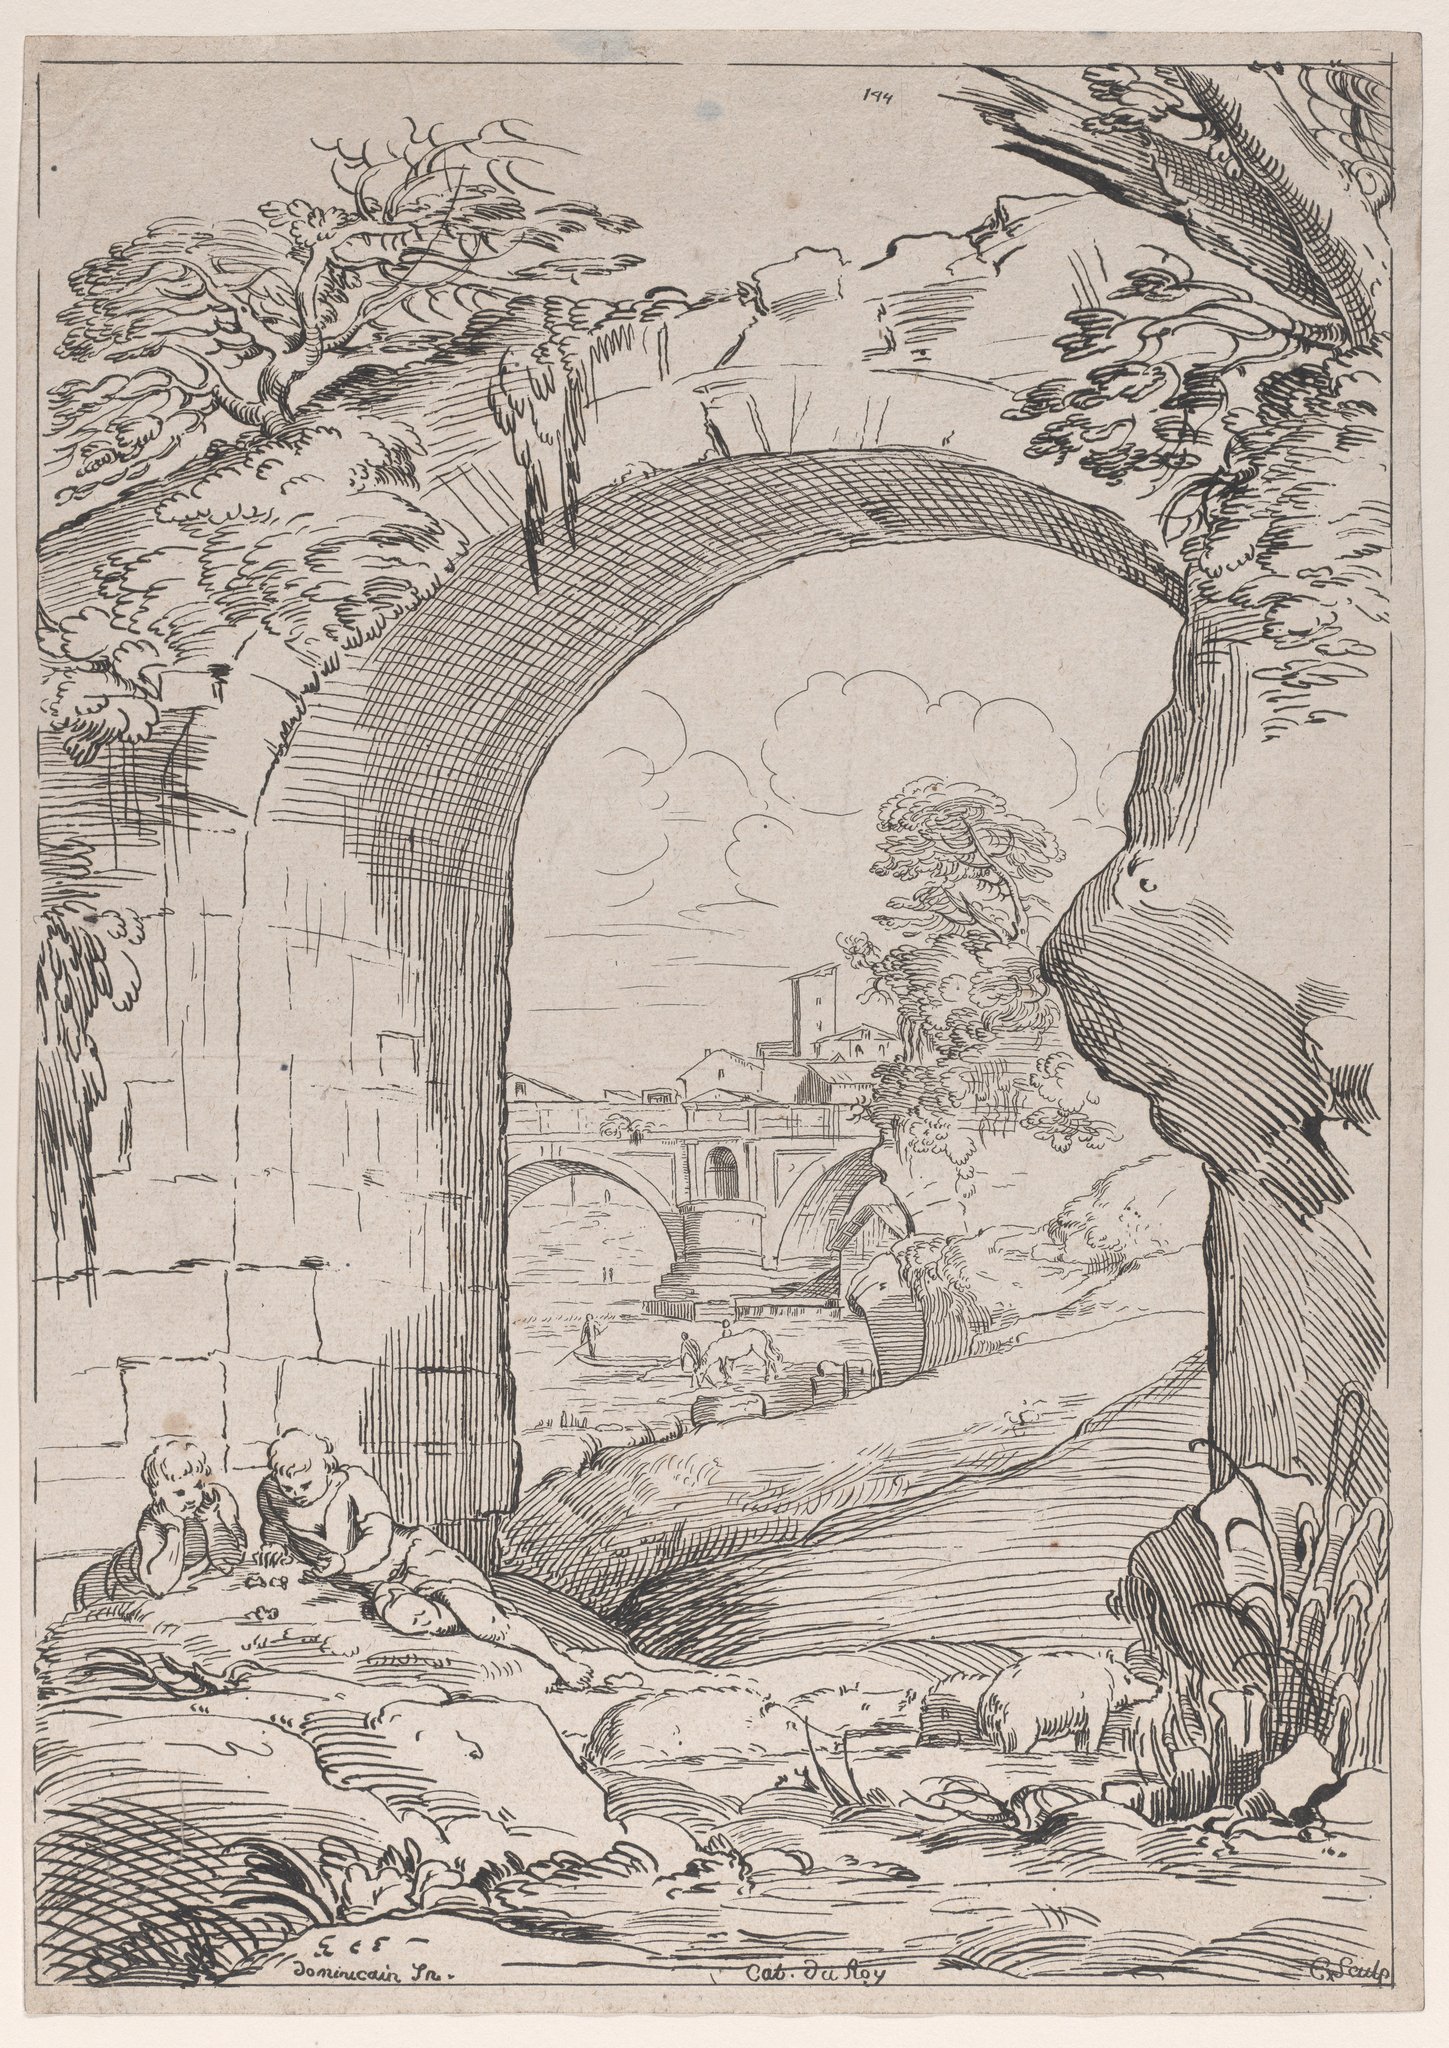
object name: print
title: Landscape with Bridge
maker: anne claude philippe de tubières, comte de caylus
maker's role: artist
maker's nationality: french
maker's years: 1692-1765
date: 1701-1800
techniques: engraving